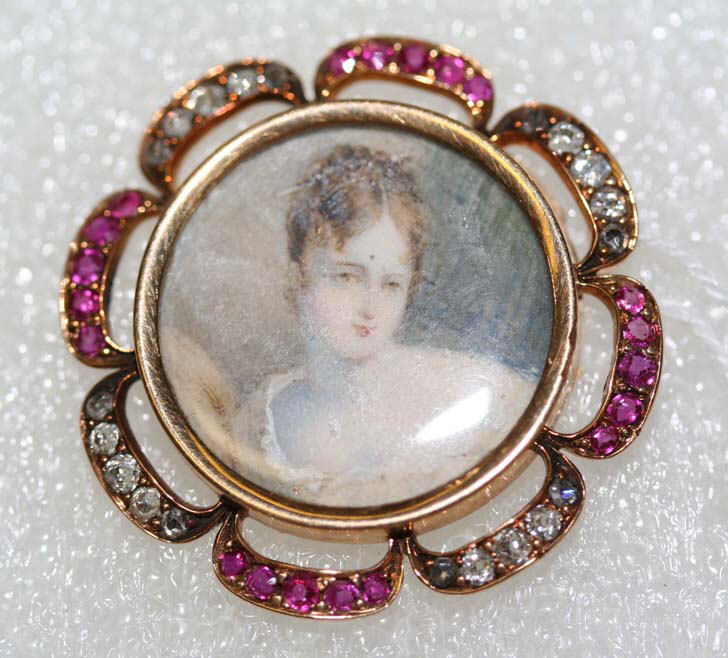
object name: button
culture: french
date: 1820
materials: diamond, glass, ivory, metal, gemstone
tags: portraits,women